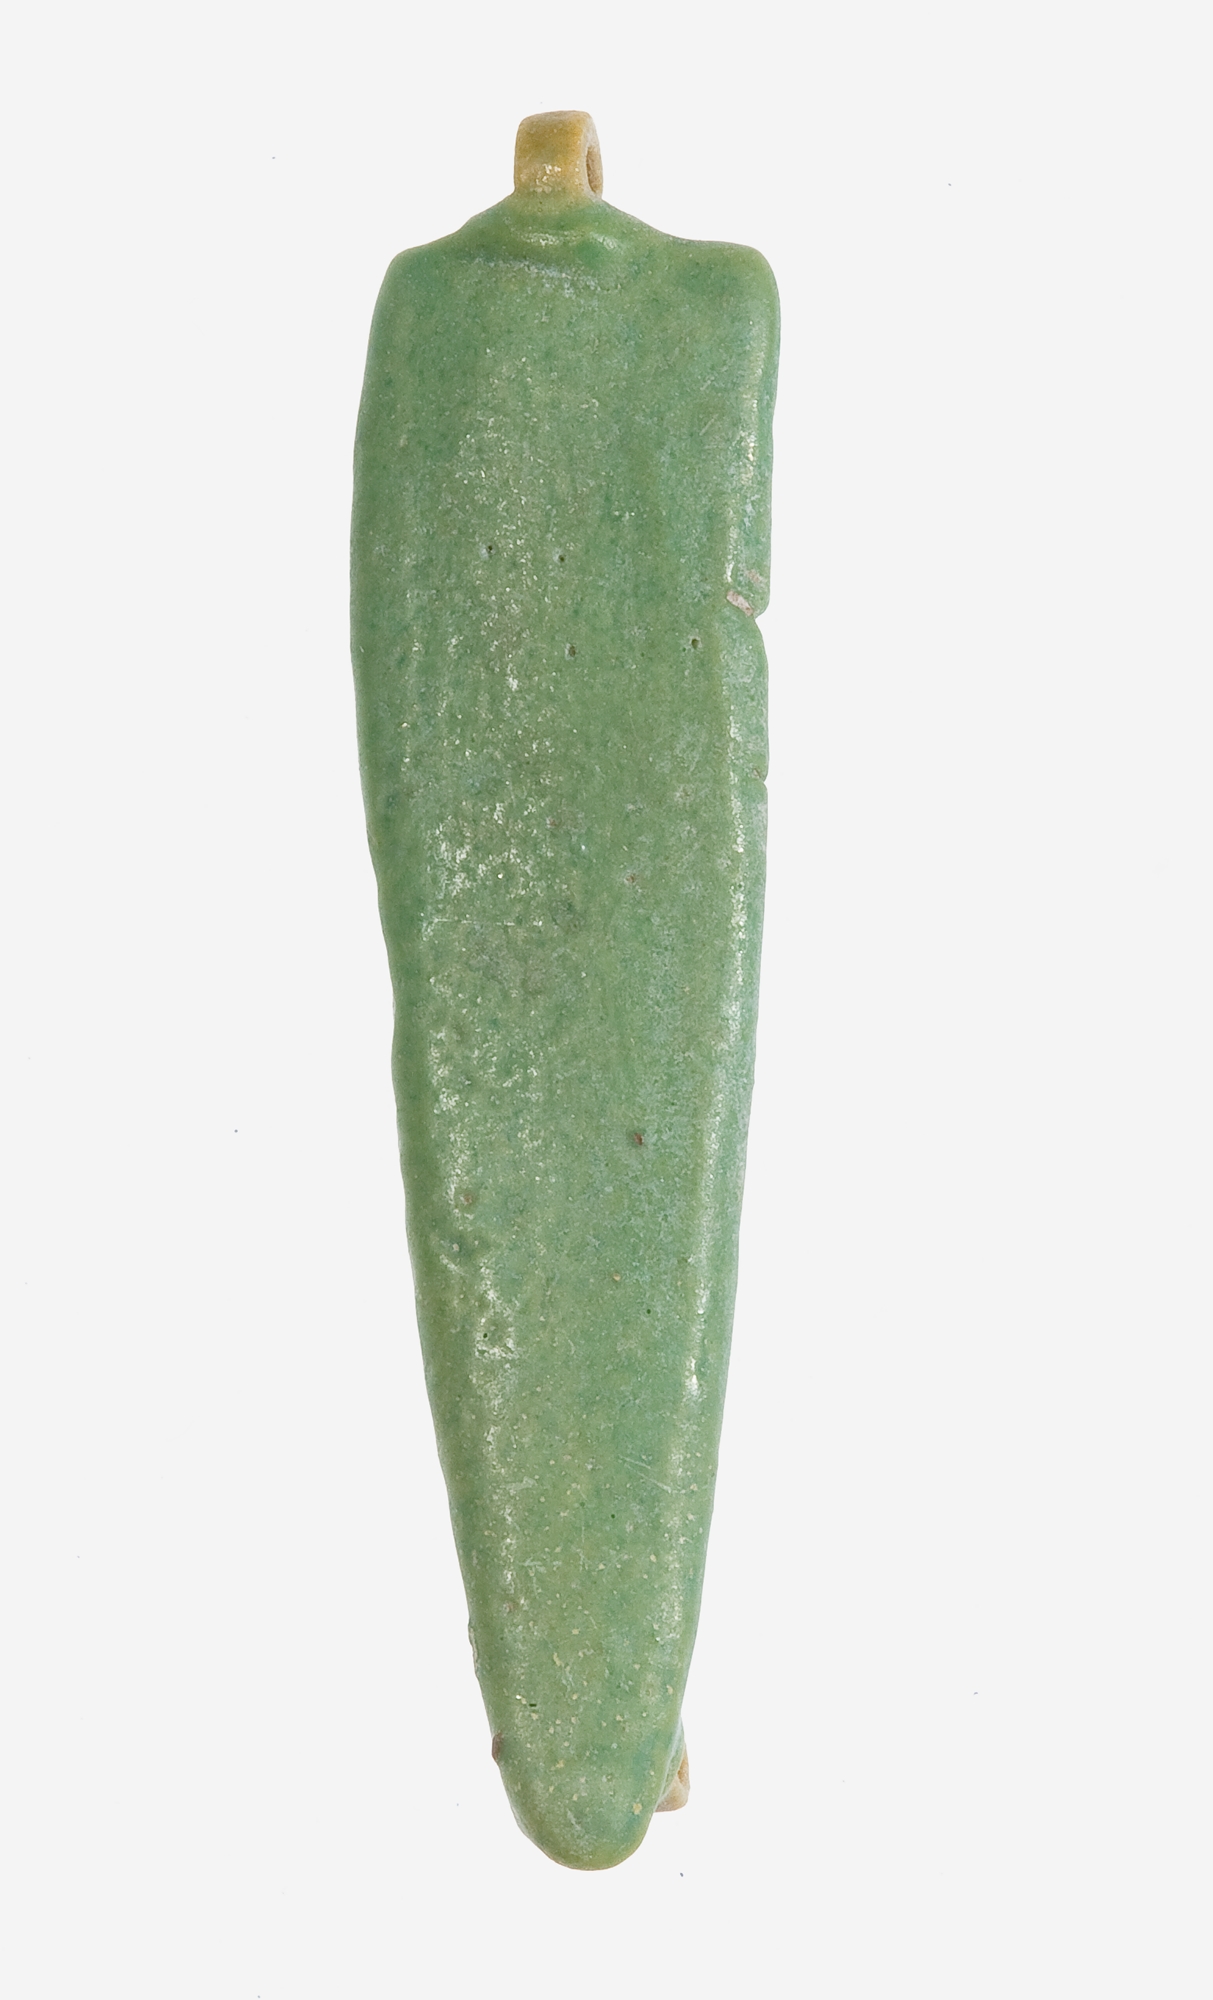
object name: pendant, leaf petal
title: Pendant: Lotus Sepal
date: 1390-1352 BCE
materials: faience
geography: egypt